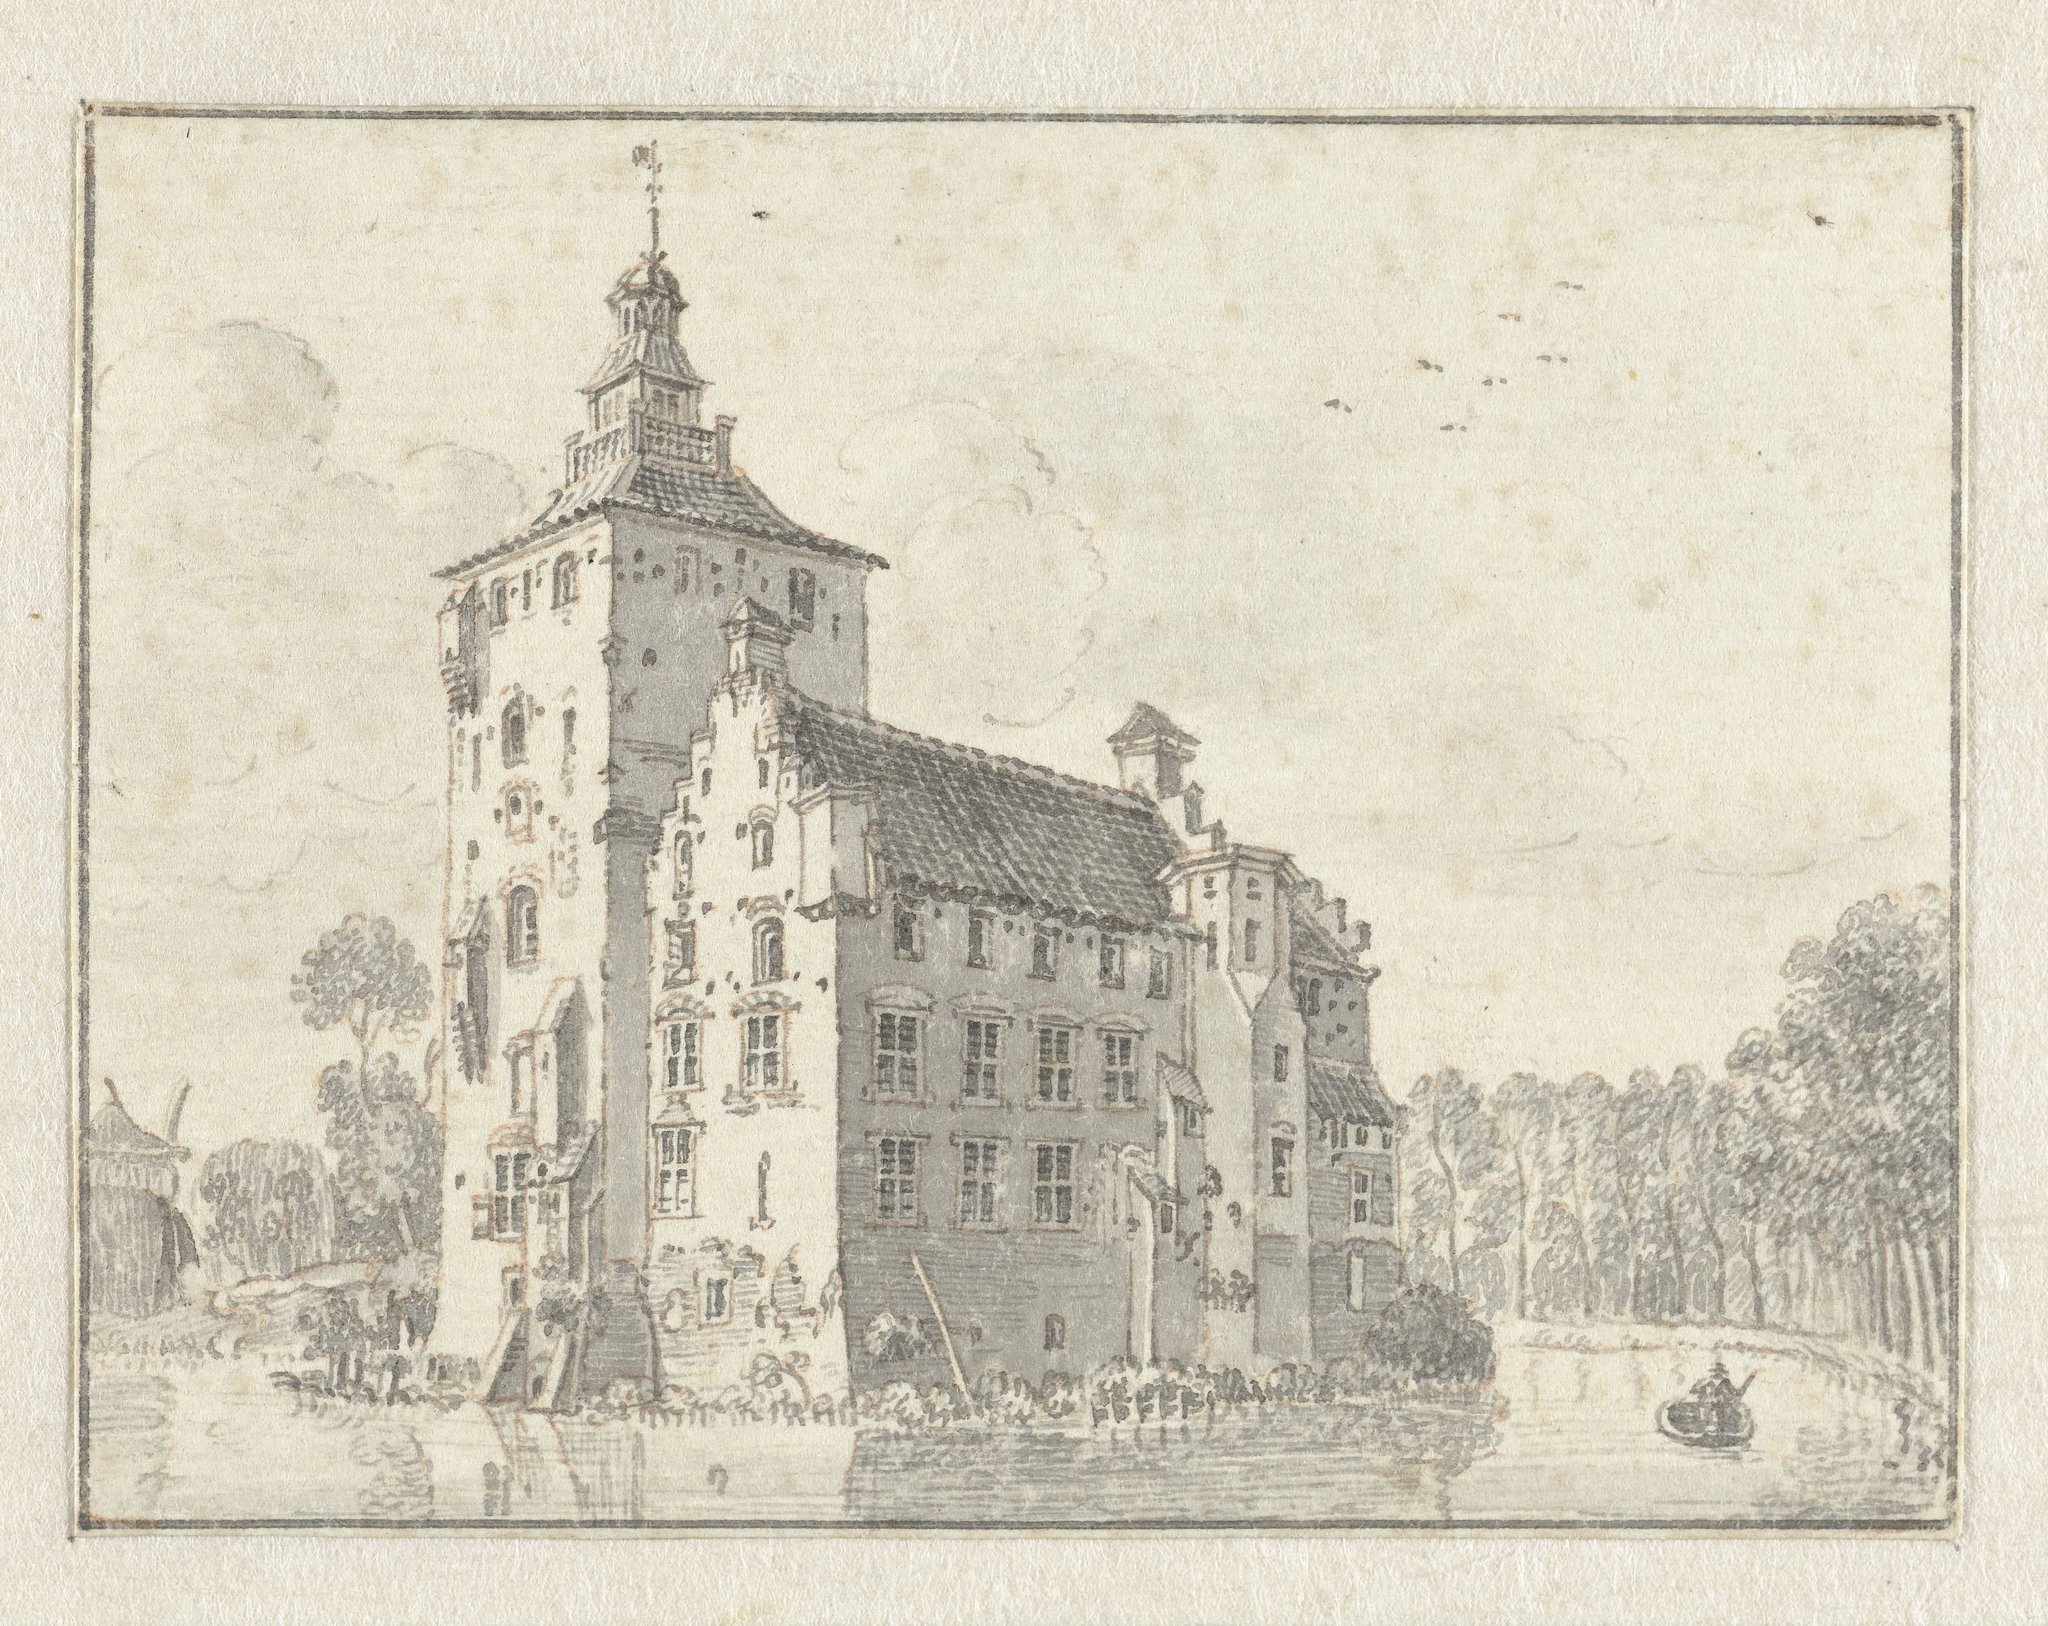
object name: drawing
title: Het huis Den Ham, bij Vleuten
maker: jan de beijer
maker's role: draughtsman, print maker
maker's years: 1703-1780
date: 1744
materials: ink, paper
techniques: brush, pen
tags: castle, vleuten